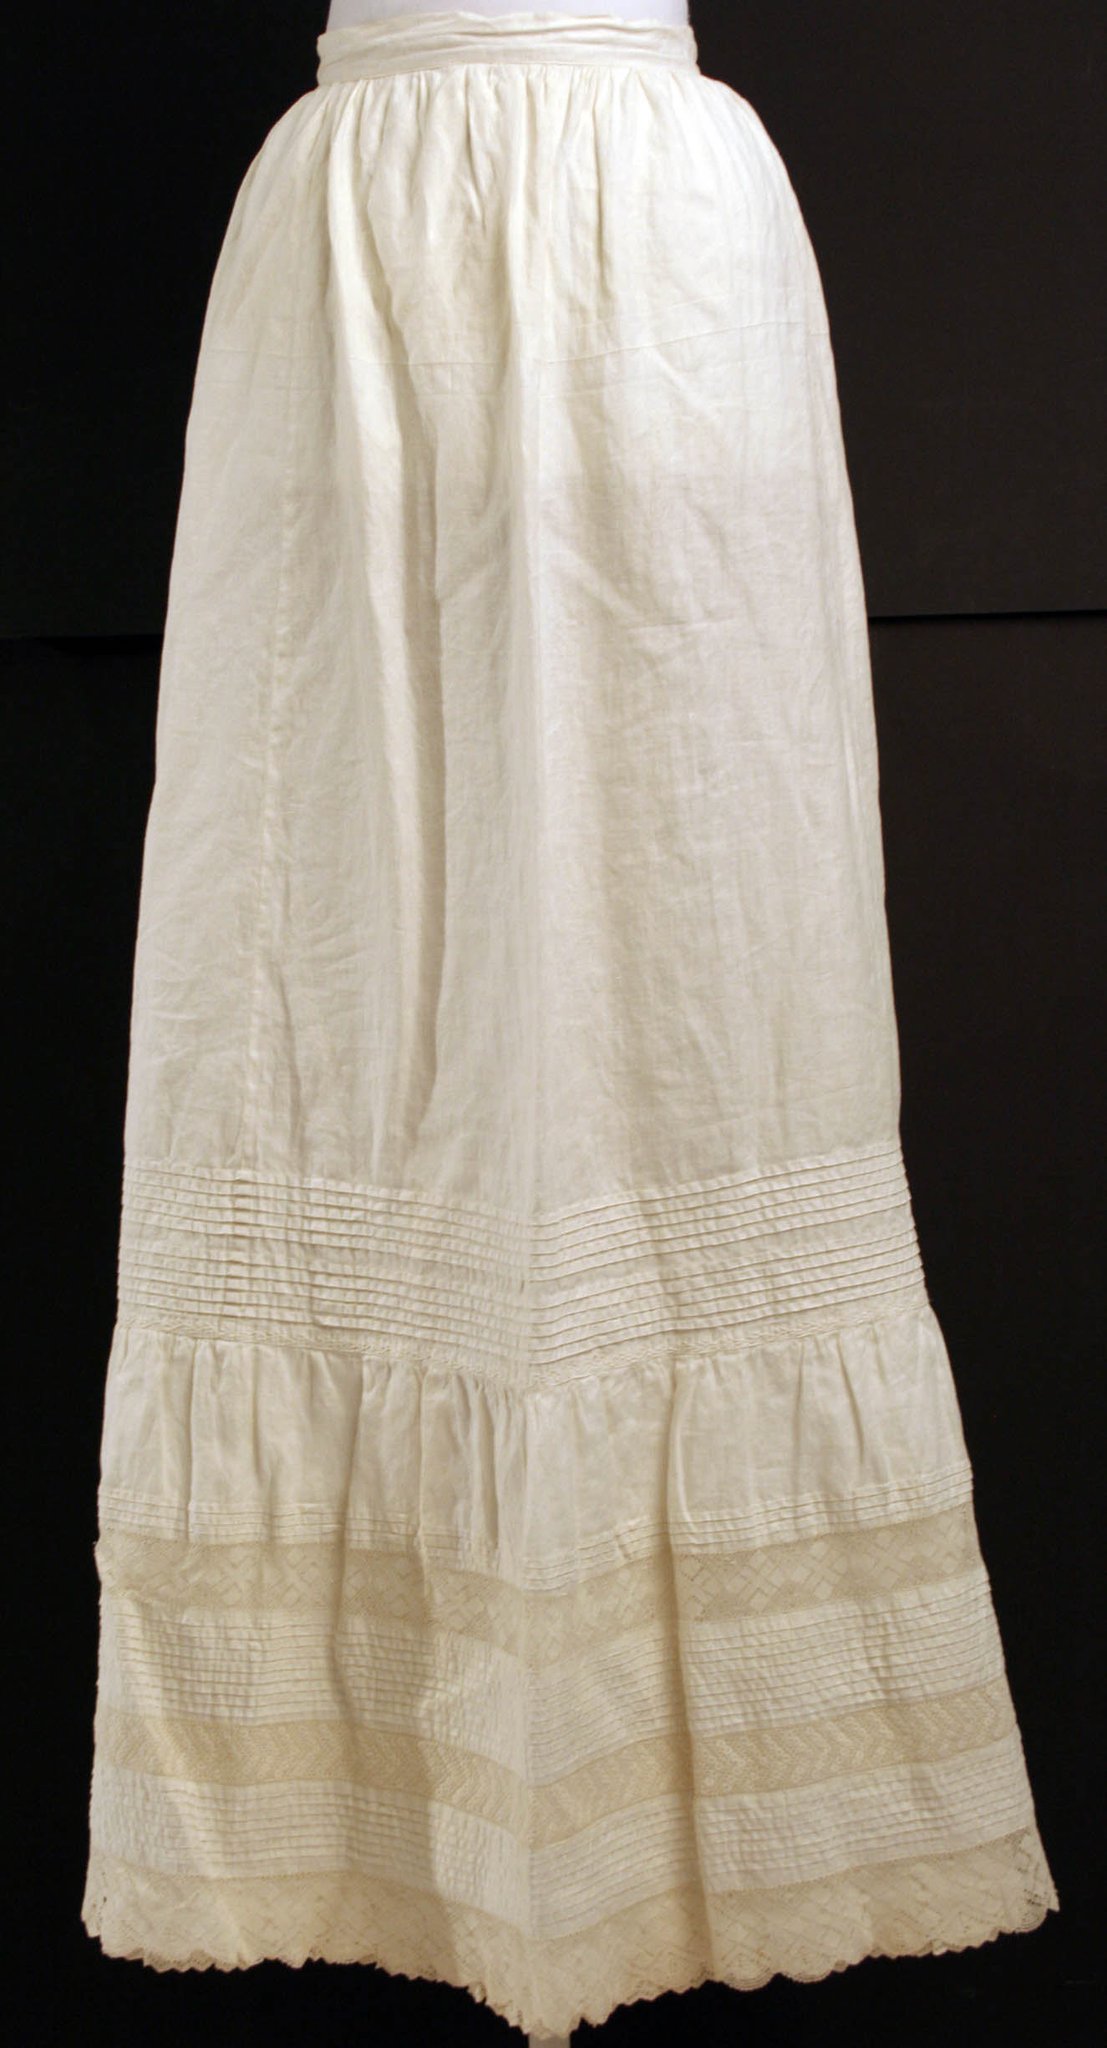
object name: petticoat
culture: american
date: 1801-1900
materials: cotton